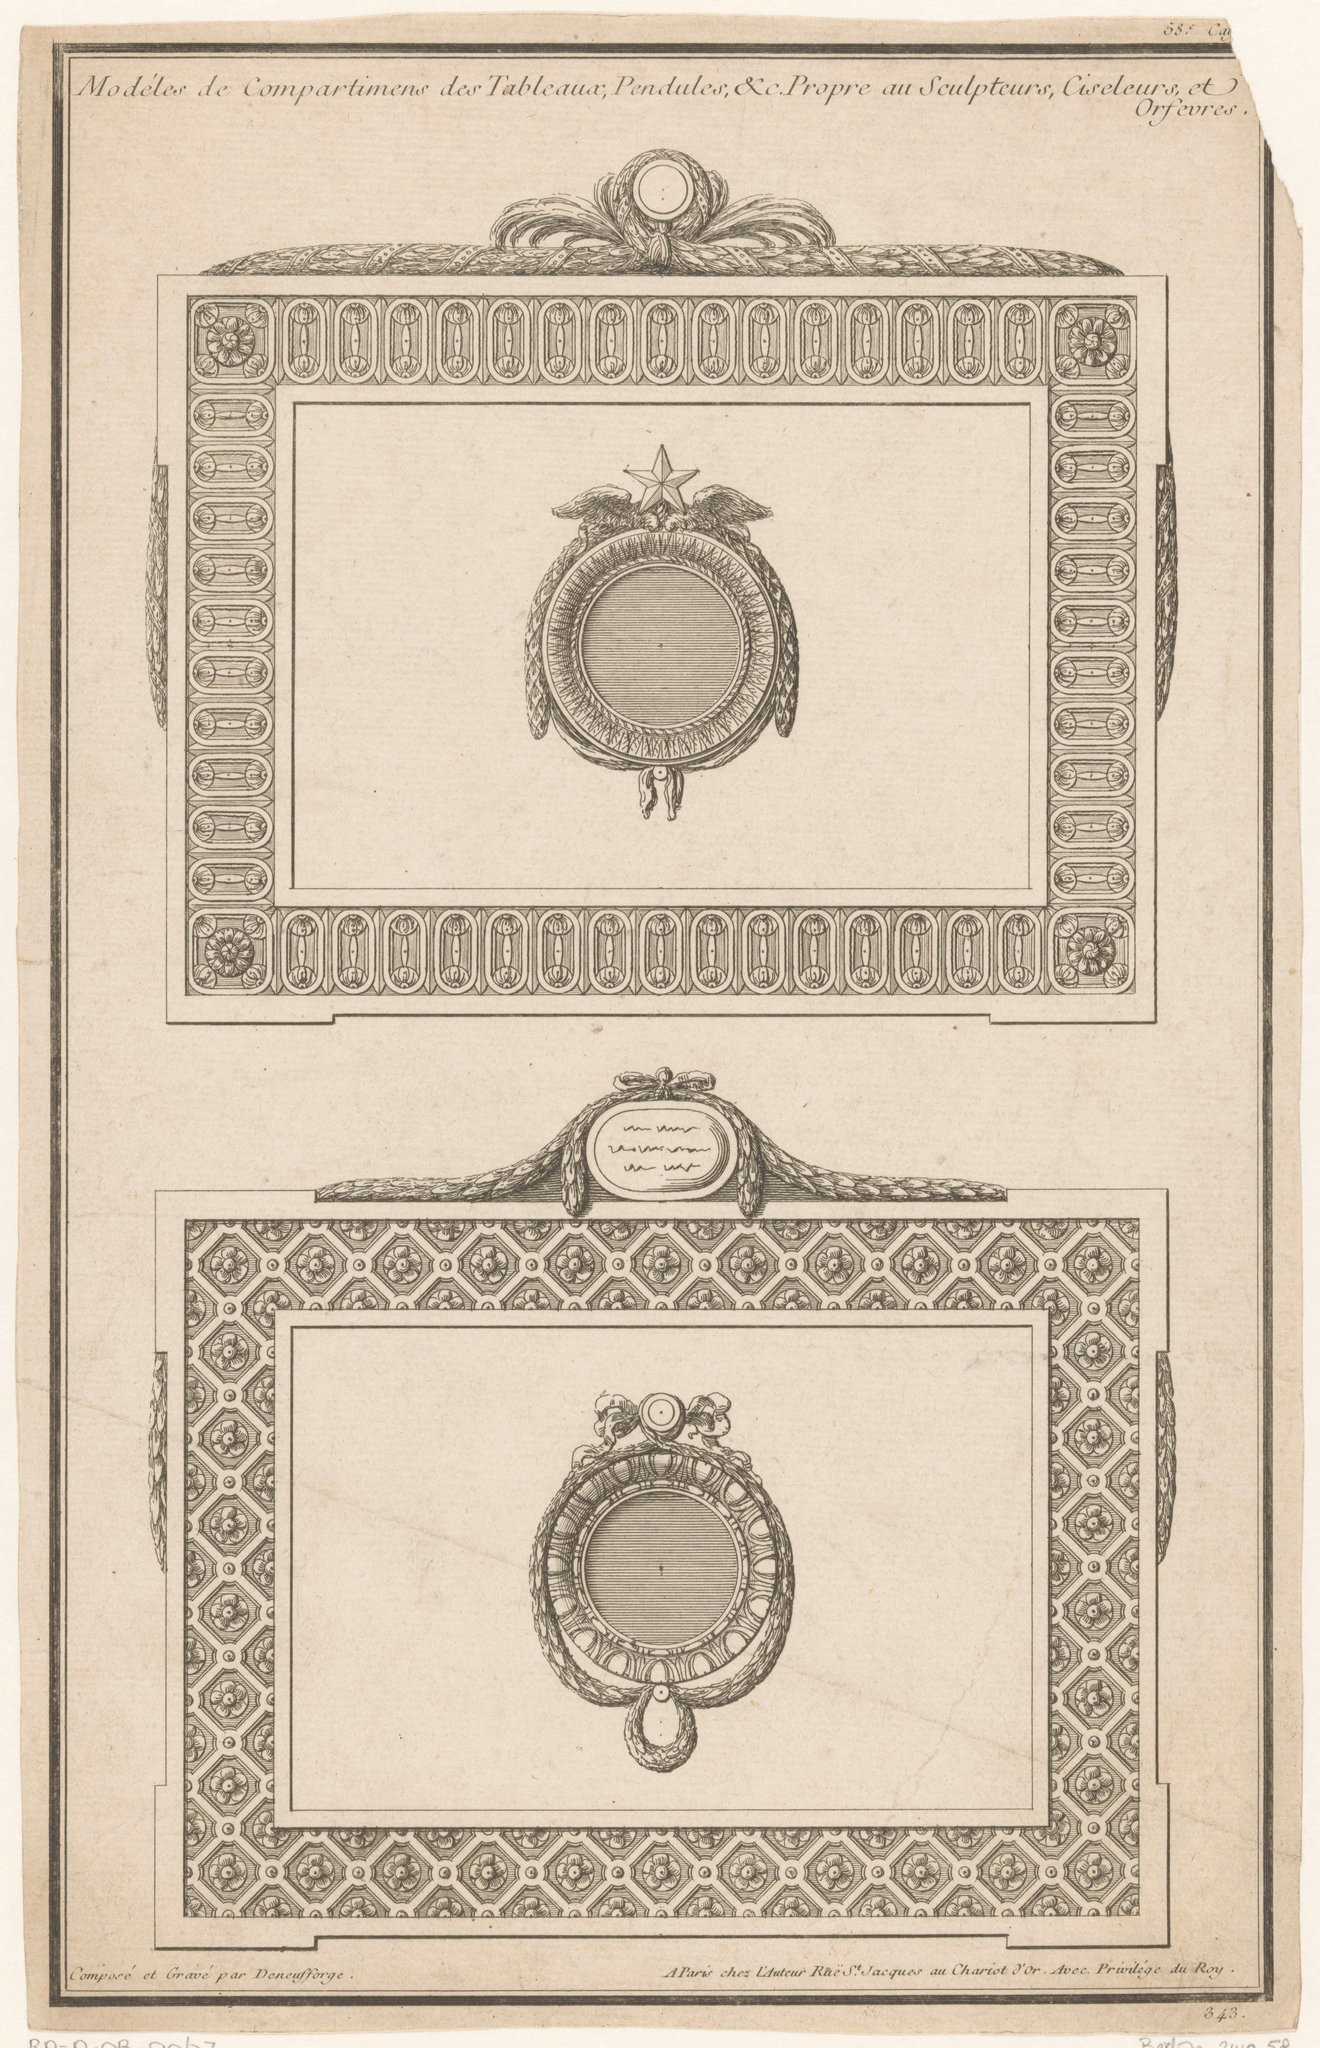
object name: print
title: Rechthoekige omlijstingen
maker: jean françois de neufforge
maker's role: print maker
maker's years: 1714-1791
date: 1763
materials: paper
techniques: etching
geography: paris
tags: ornaments ~ art (+ framing decorations)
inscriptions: collector's mark: Lugt 2228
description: Twee rechthoekige omlijstingen met bloemmotieven en guirlandes, in het midden twee ronde omlijstingen met een ster, vleugels, guirlandes en eierlijst. Prentnummer 343.